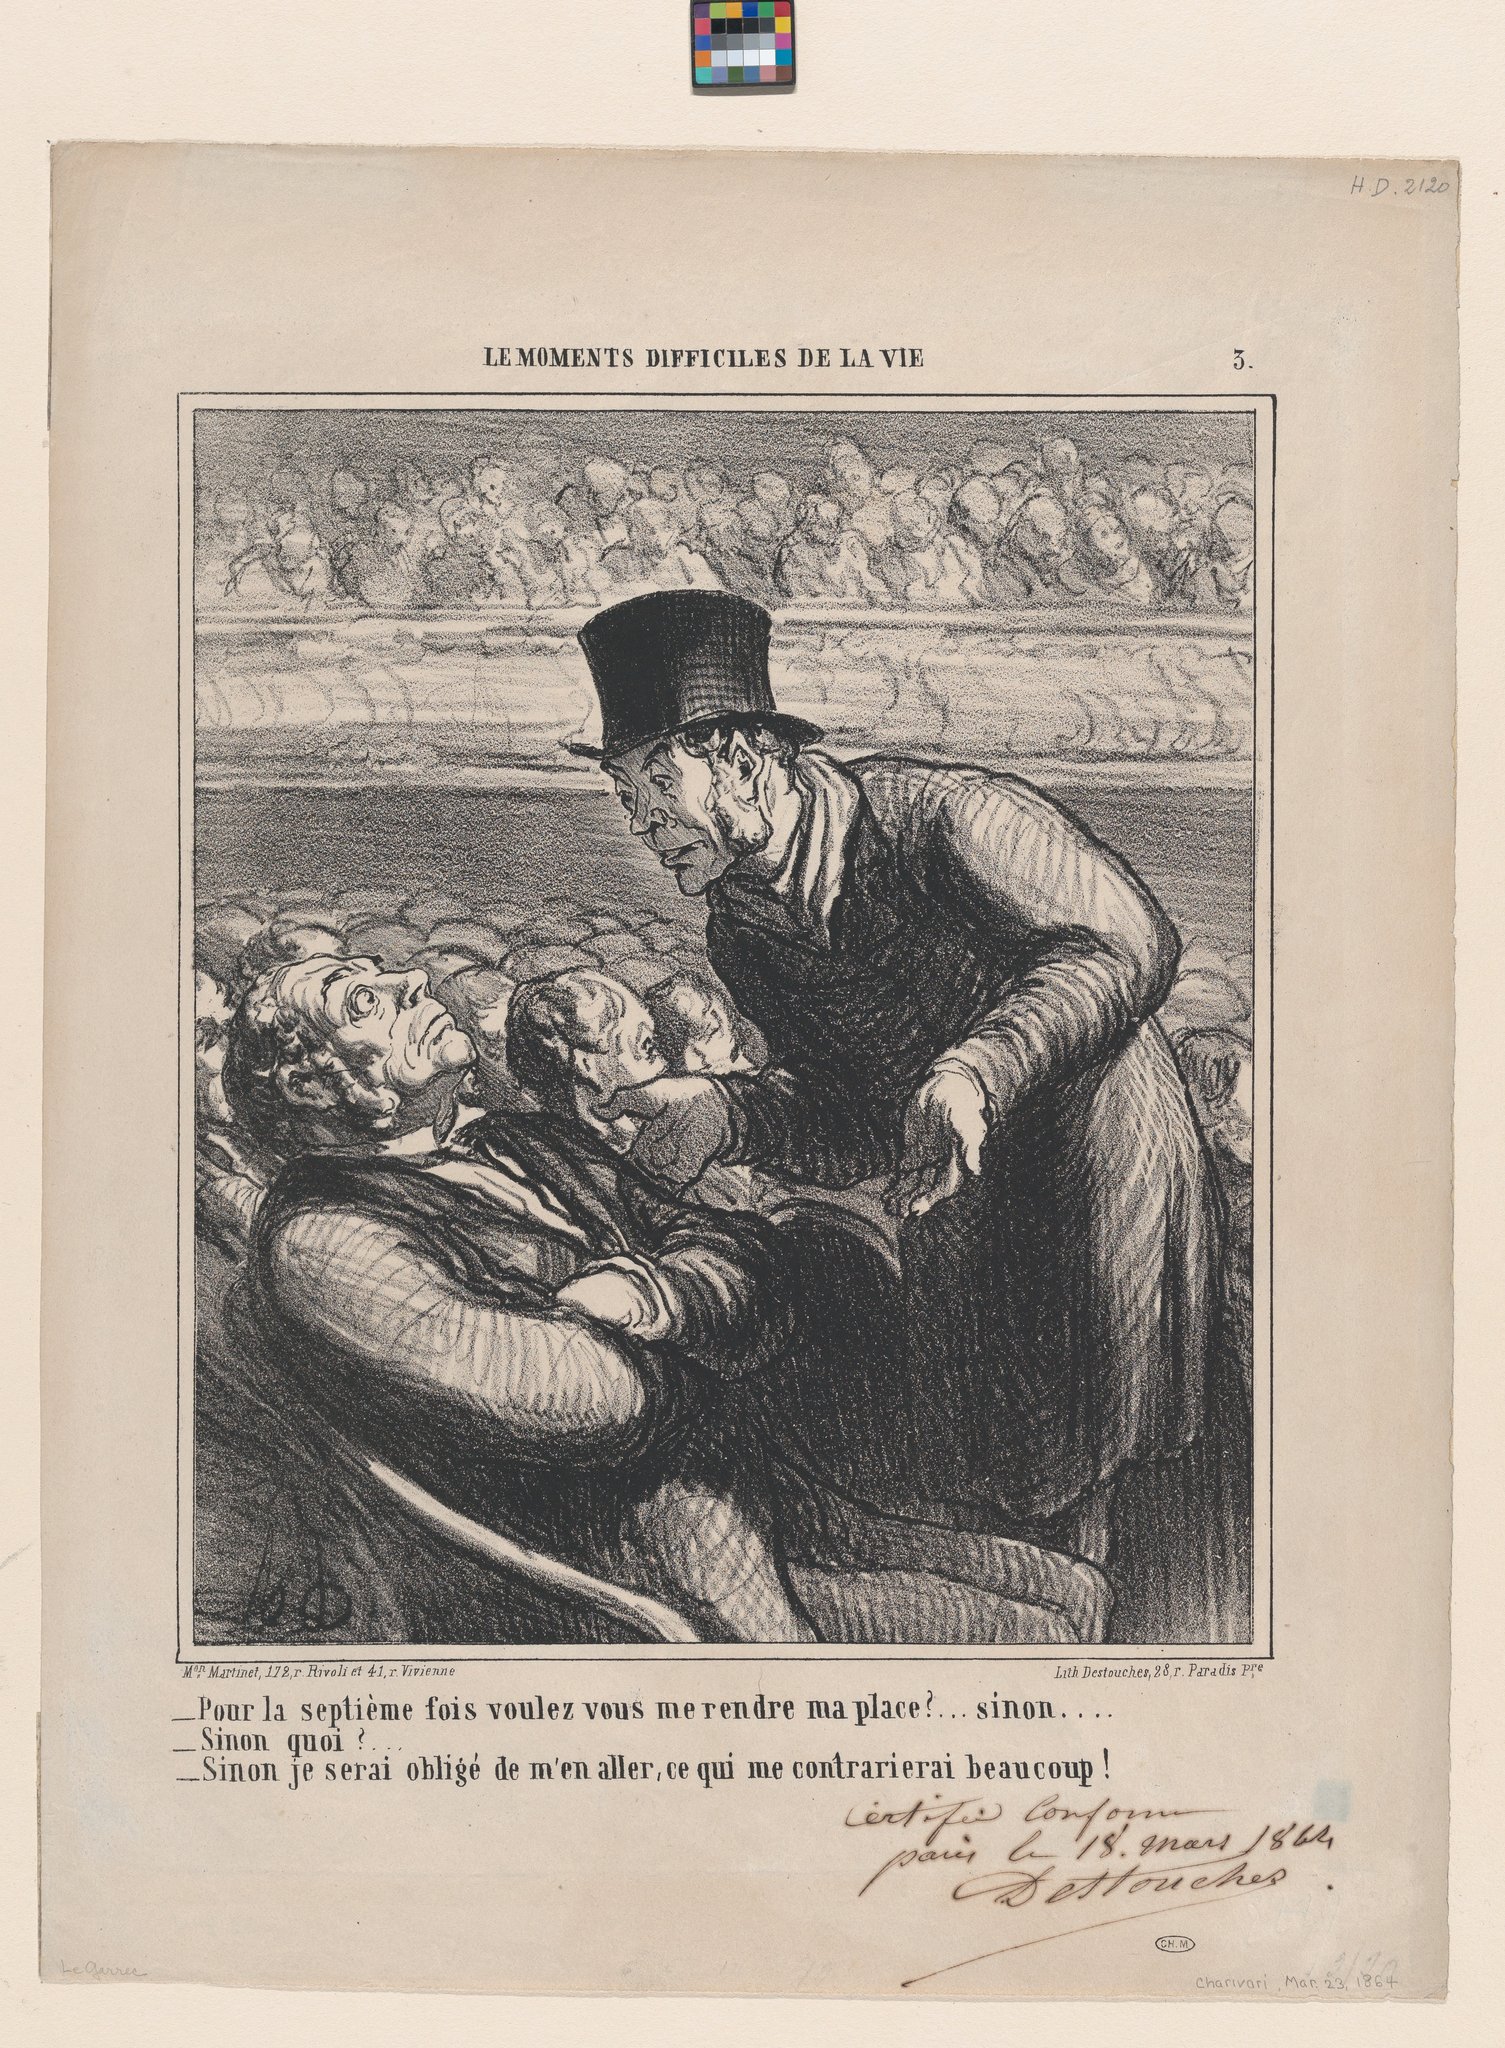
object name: print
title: For the seventh time..... will you please leave my seat? otherwise..., from 'The difficult moments of life'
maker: honoré daumier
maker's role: artist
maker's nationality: french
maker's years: 1808-1879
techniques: lithograph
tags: men,crowd